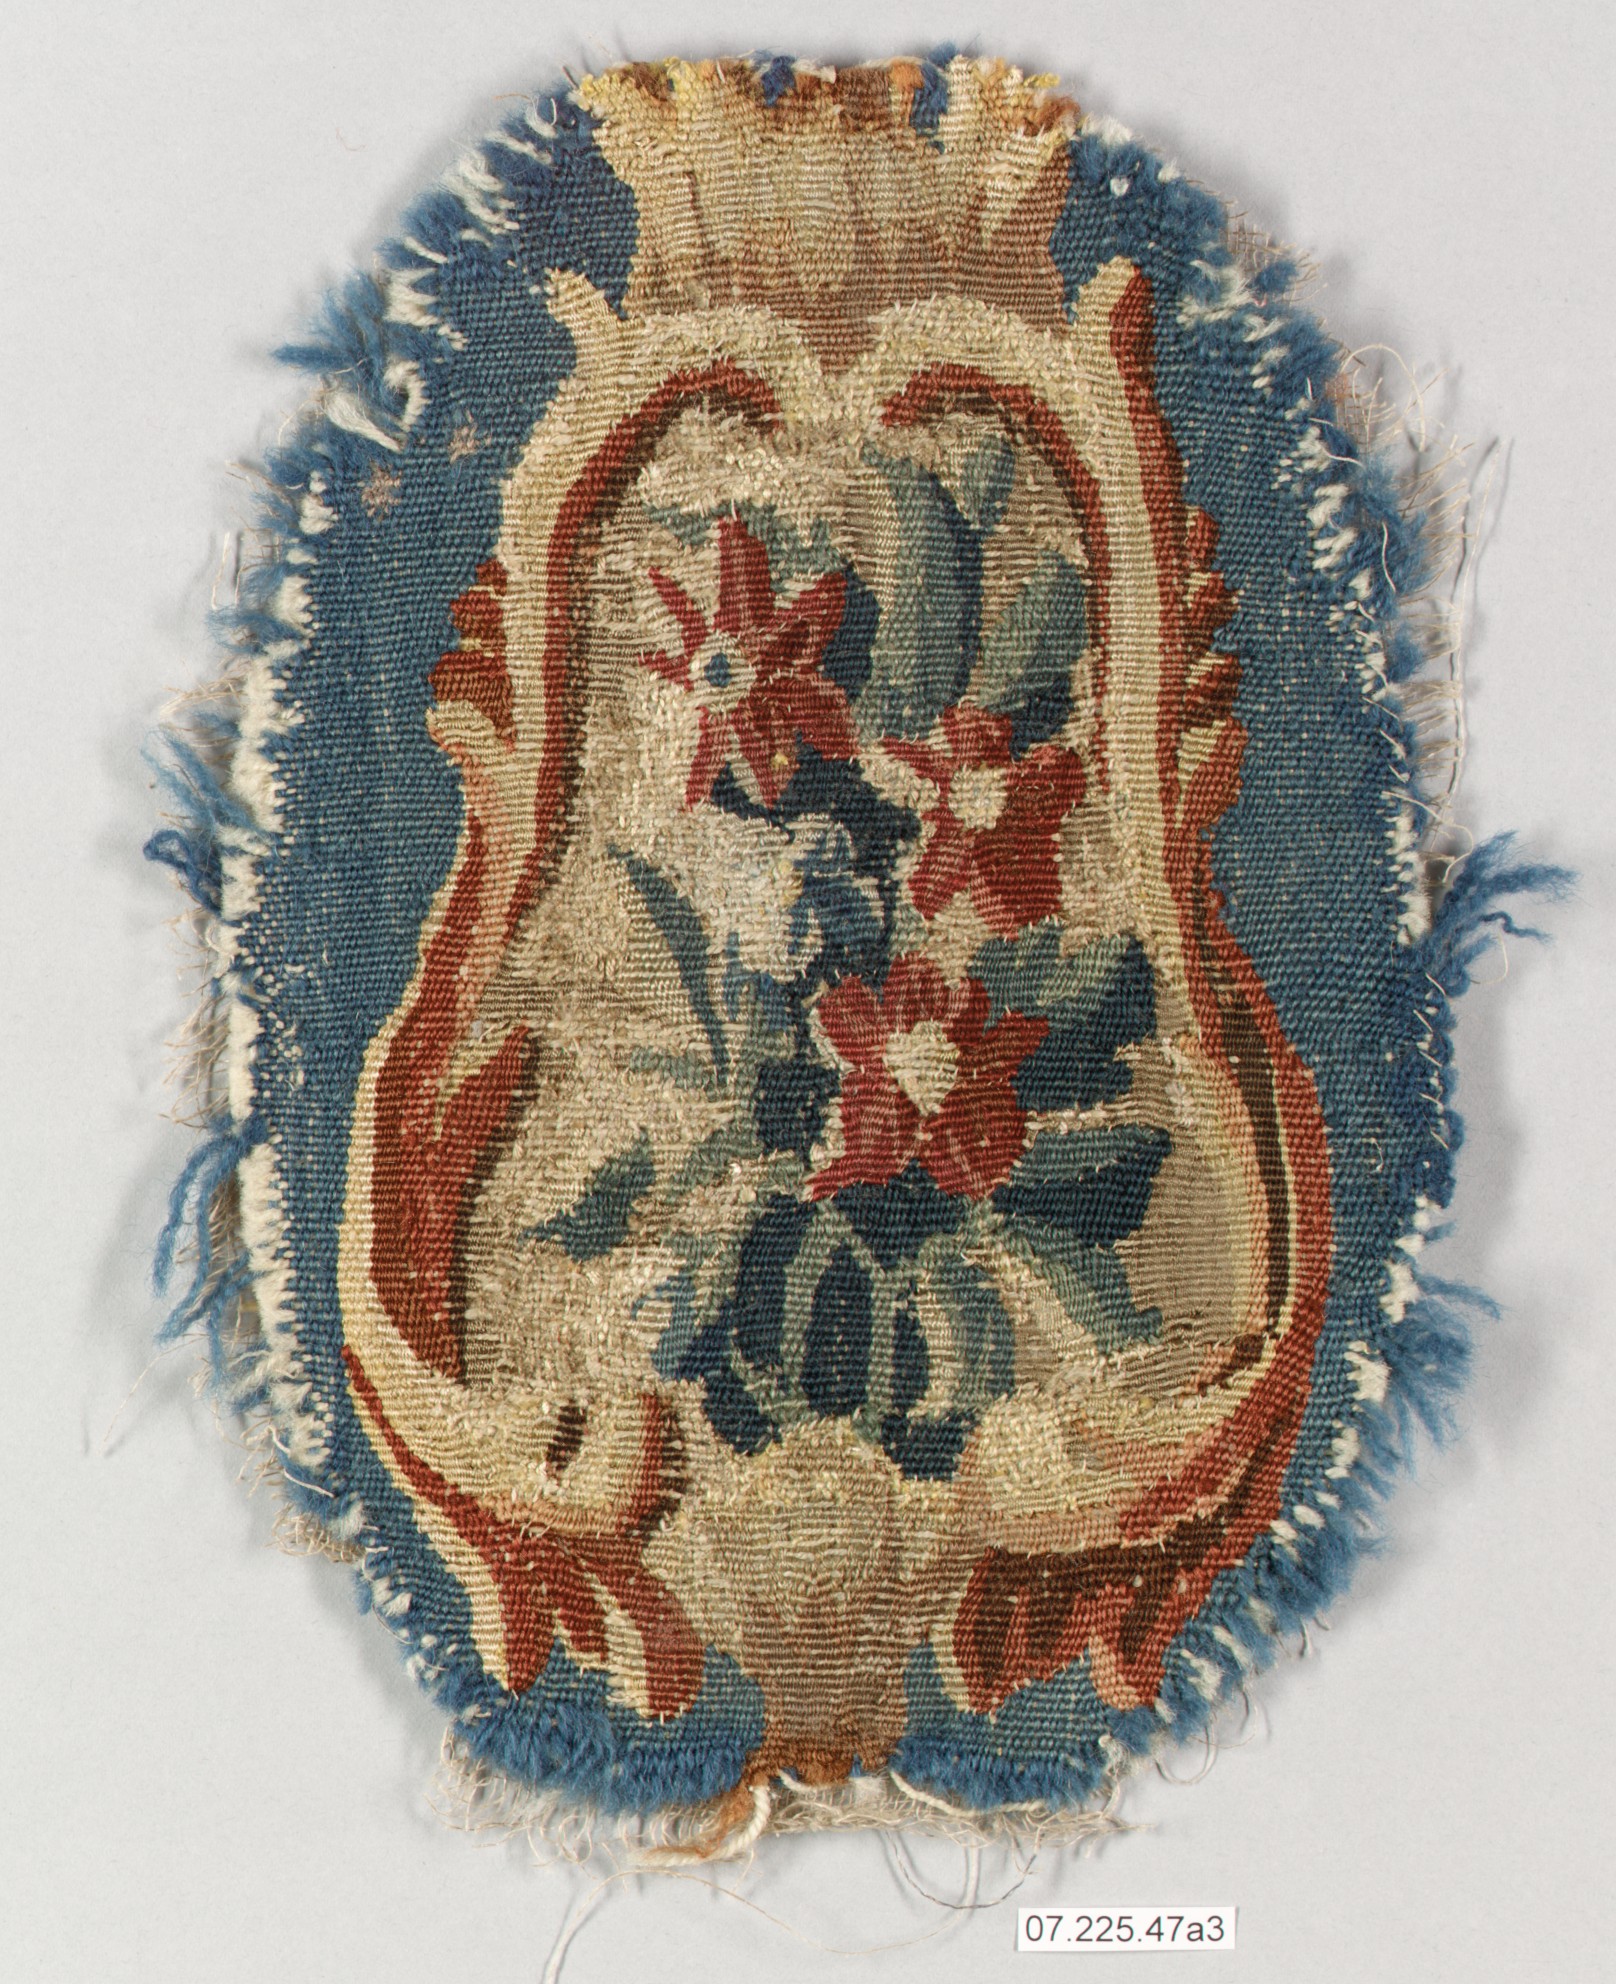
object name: upholstery panel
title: Rocaille cartouche with flowers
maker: beauvais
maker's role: manufactory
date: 1735-1750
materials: silk, wool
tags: flowers